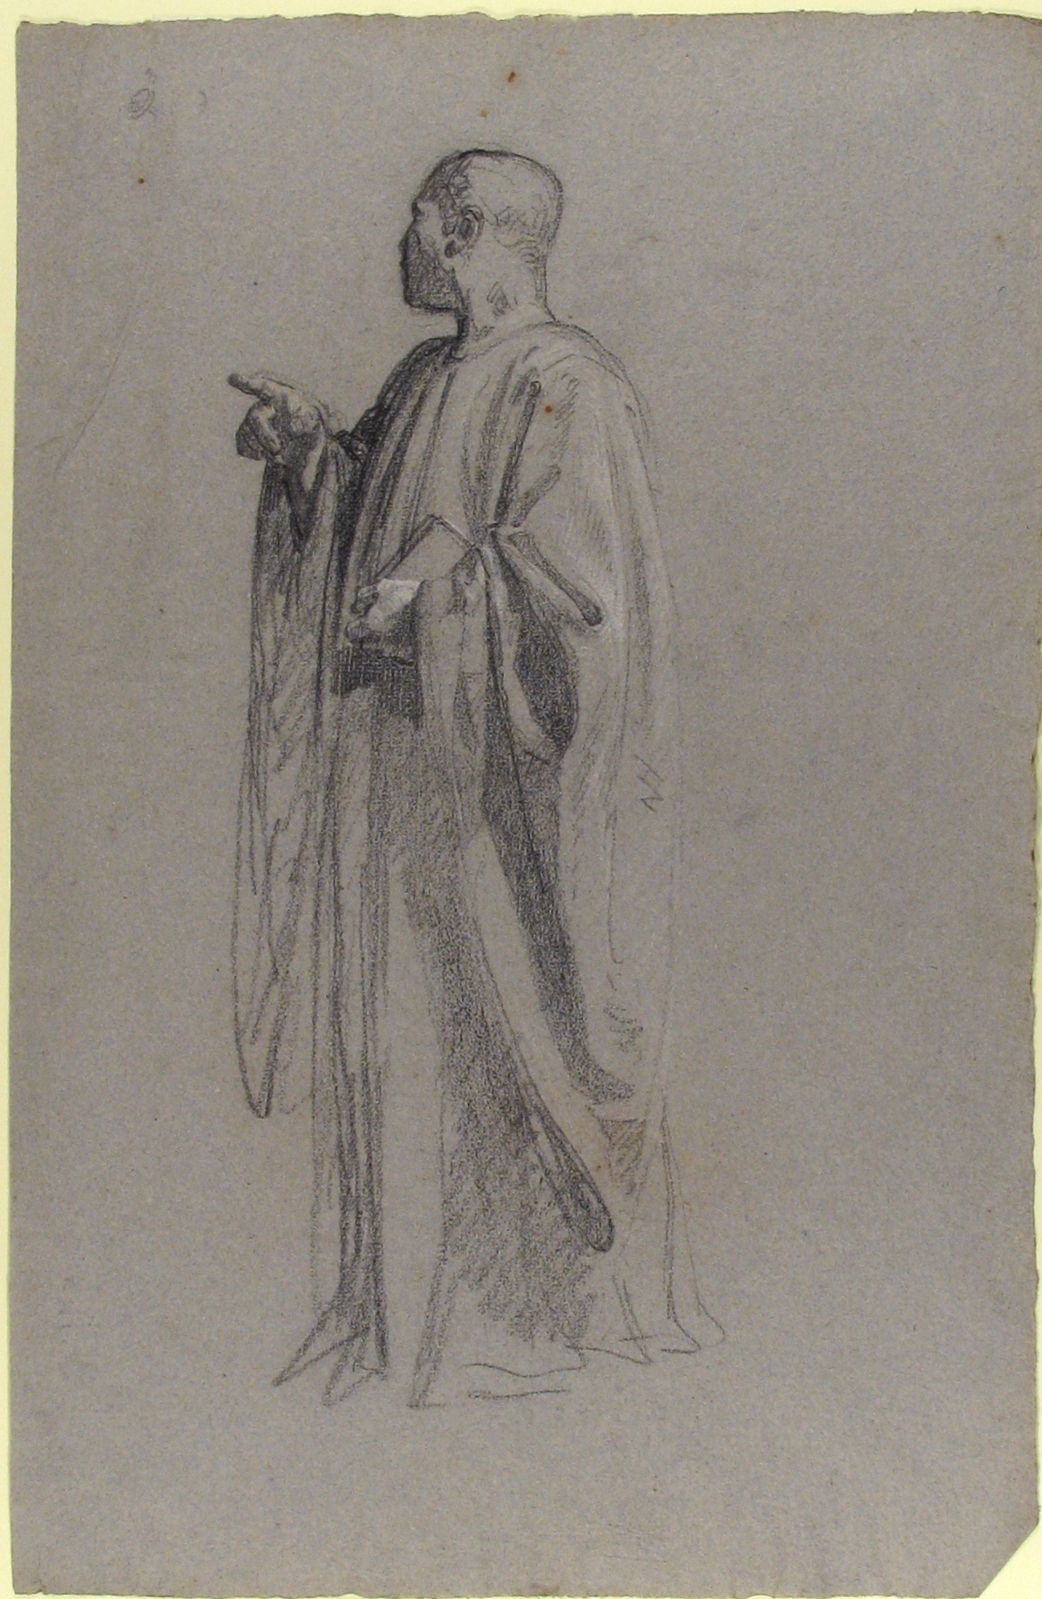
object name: drawing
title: Cleric (lower register; study for wall paintings in the Chapel of Saint Remi, Sainte-Clotilde, Paris, 1858)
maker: isidore pils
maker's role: artist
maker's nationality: french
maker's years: 1813-1875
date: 1801-1900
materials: chalk, paper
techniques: heightening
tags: men